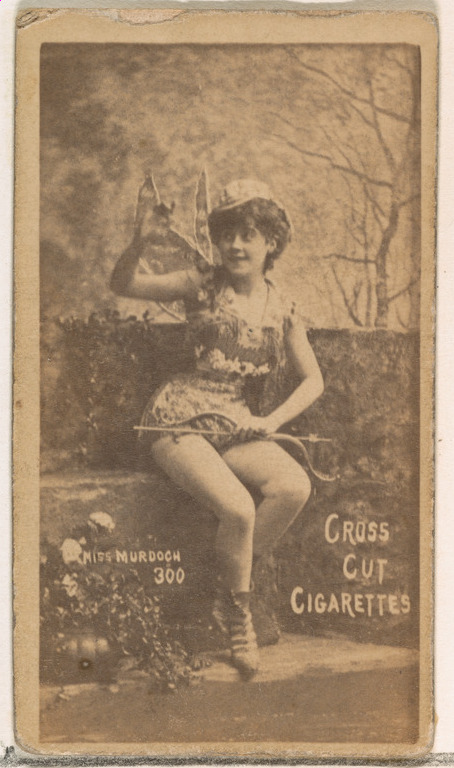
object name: print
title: Card Number 300, Miss Murdoch, from the Actors and Actresses series (N145-1) issued by Duke Sons & Co. to promote Cross Cut Cigarettes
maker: w. duke, sons & co.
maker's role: publisher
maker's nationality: american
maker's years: 1870-1920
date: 1880-1889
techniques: albumen silver print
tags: portraits,women,actresses